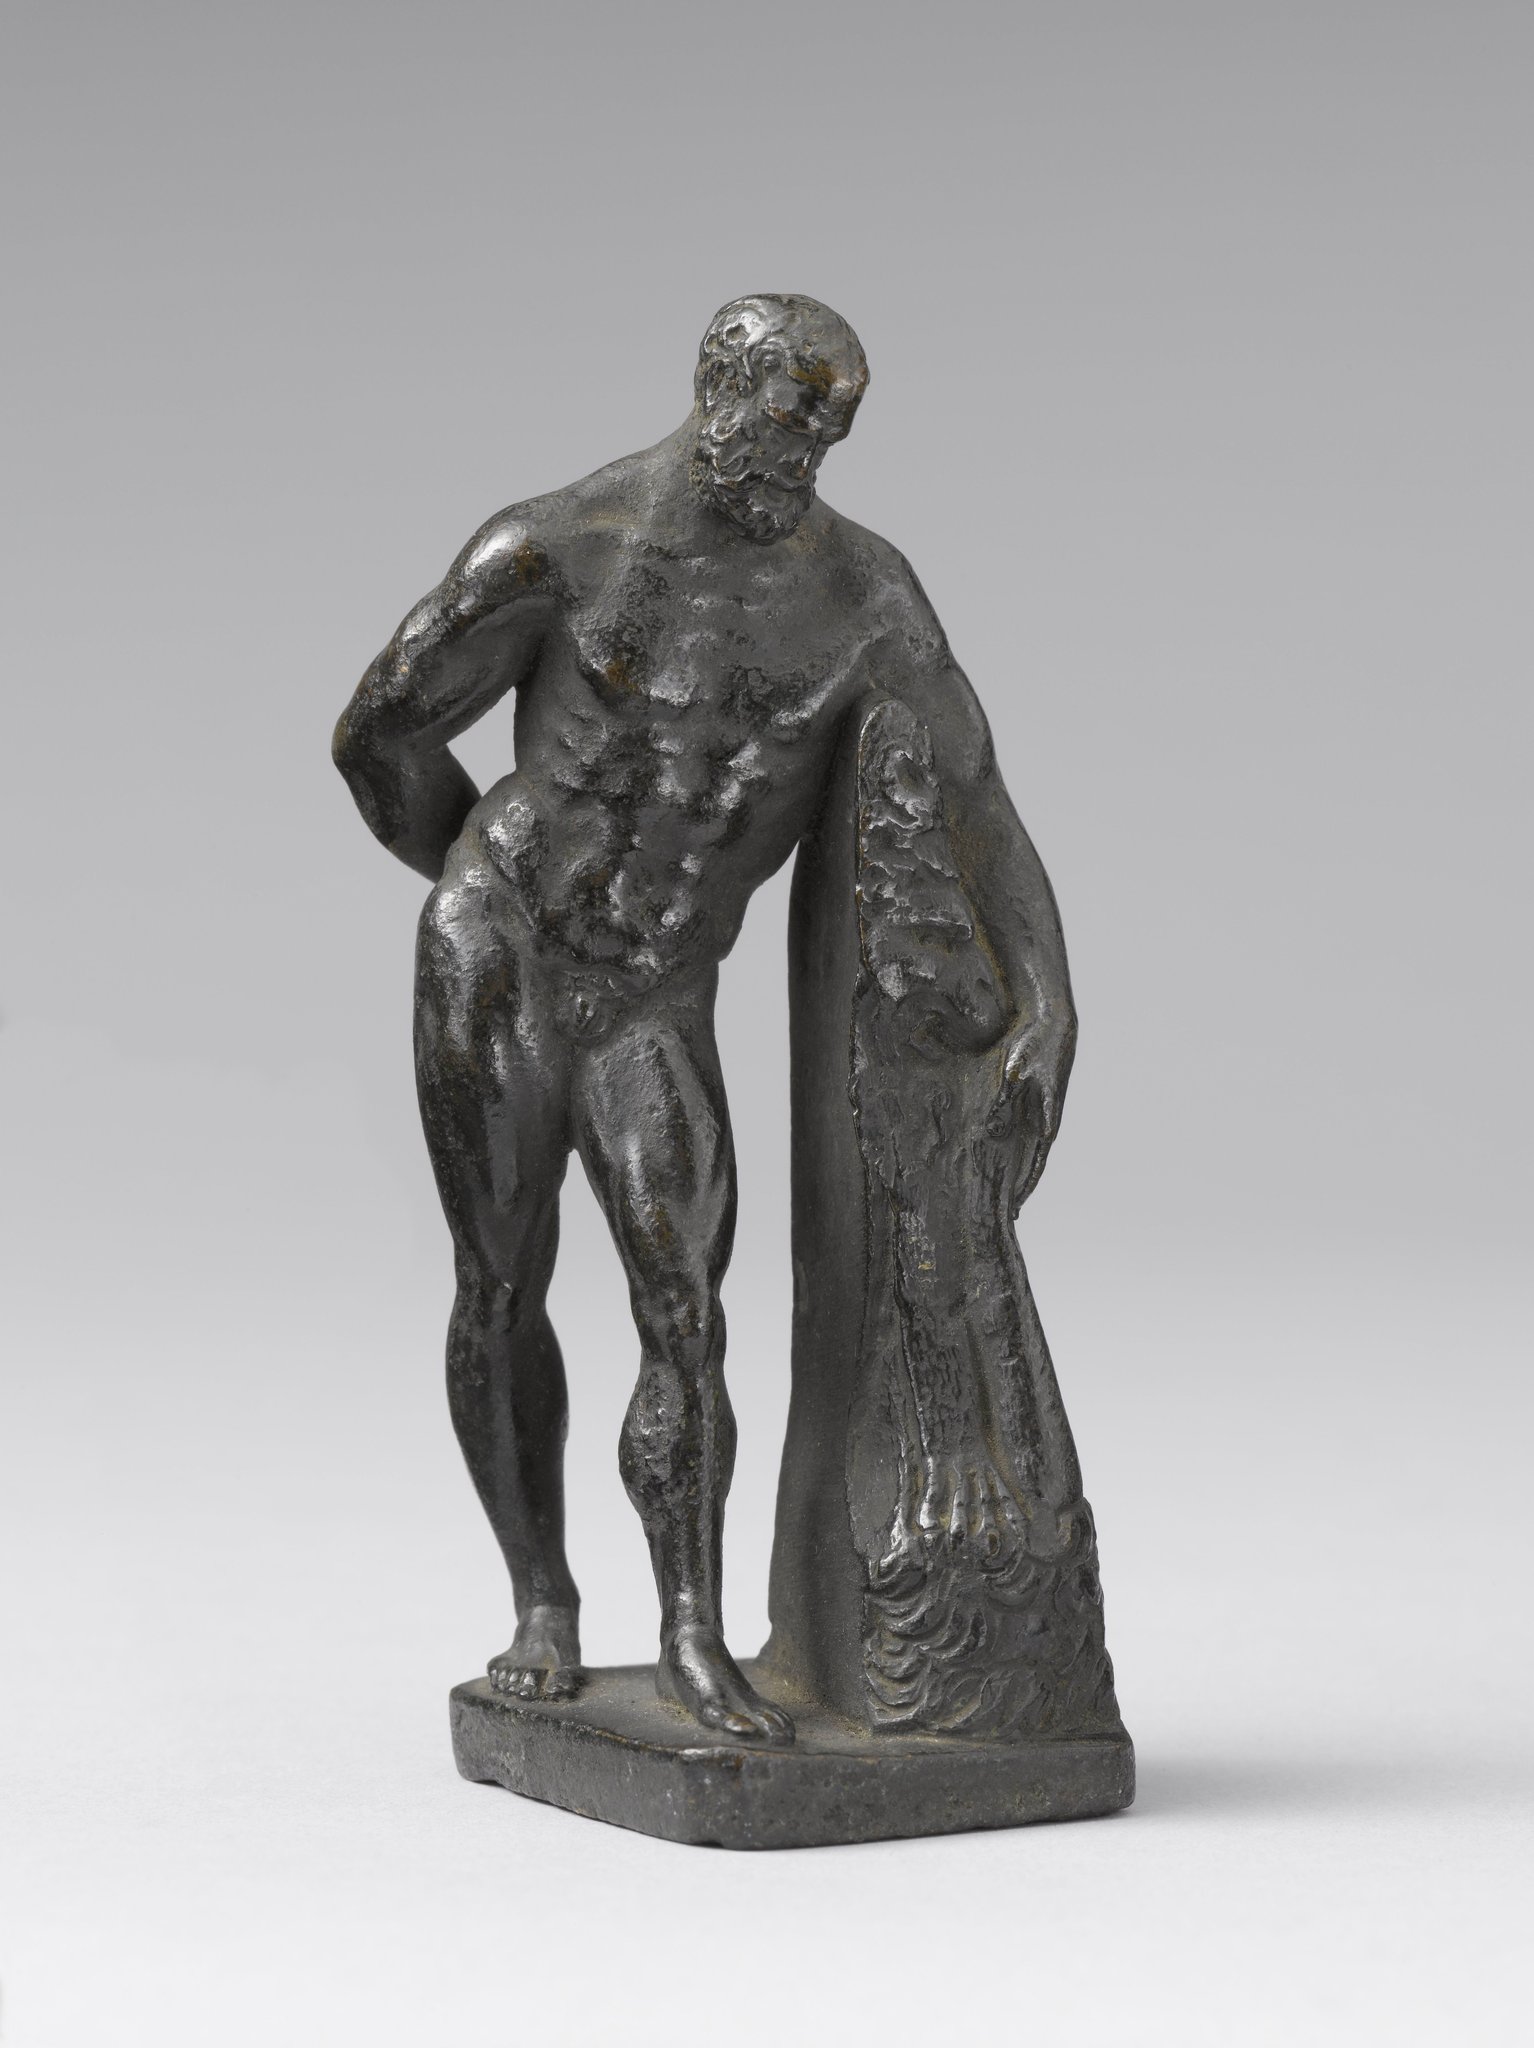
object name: sculpture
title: Hercules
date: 1550-1600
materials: bronze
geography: italy